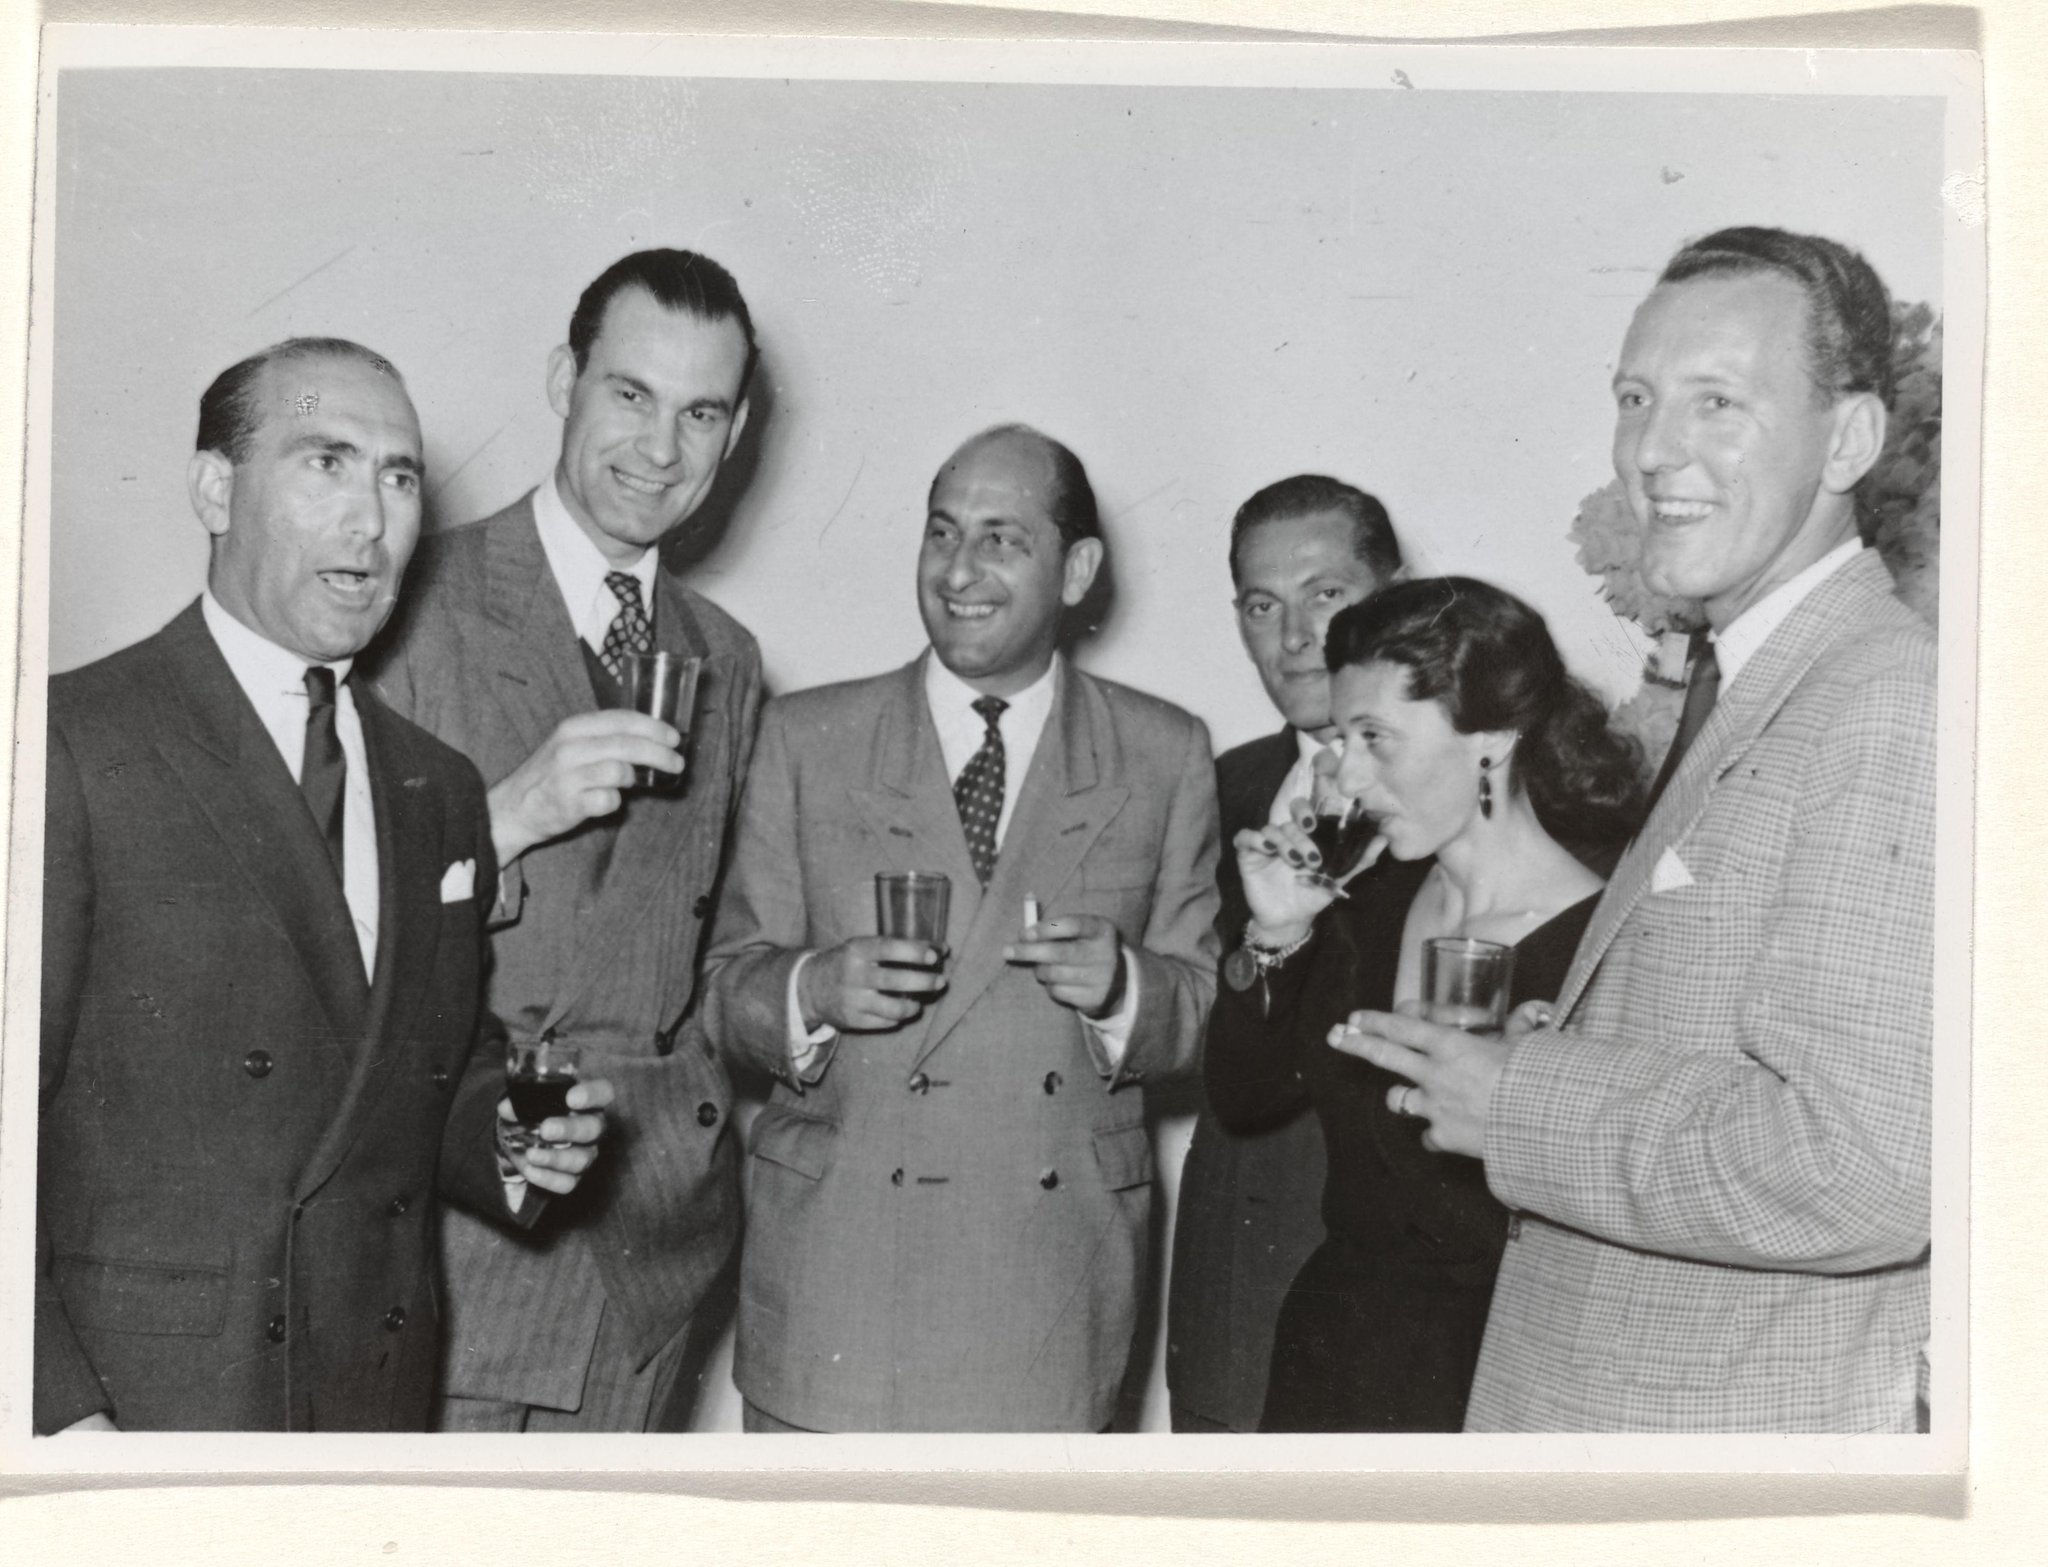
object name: photograph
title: Gideon Elon met vier onbekende mannen en een onbekende vrouw, tijdens een receptie gedurende de KLM-tijd van Isabel Wachenheimer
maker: Anonymous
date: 1956-1973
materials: photographic support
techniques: gelatin silver print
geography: israel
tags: gideon elon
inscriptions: number: ‘1686/5 Copyright by photo-attar (at the yard), 16, Mendele St. Tel-Aviv, Israel’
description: Gideon Elon (derde van rechts) met vier onbekende mannen en een onbekende vrouw, tijdens een receptie.